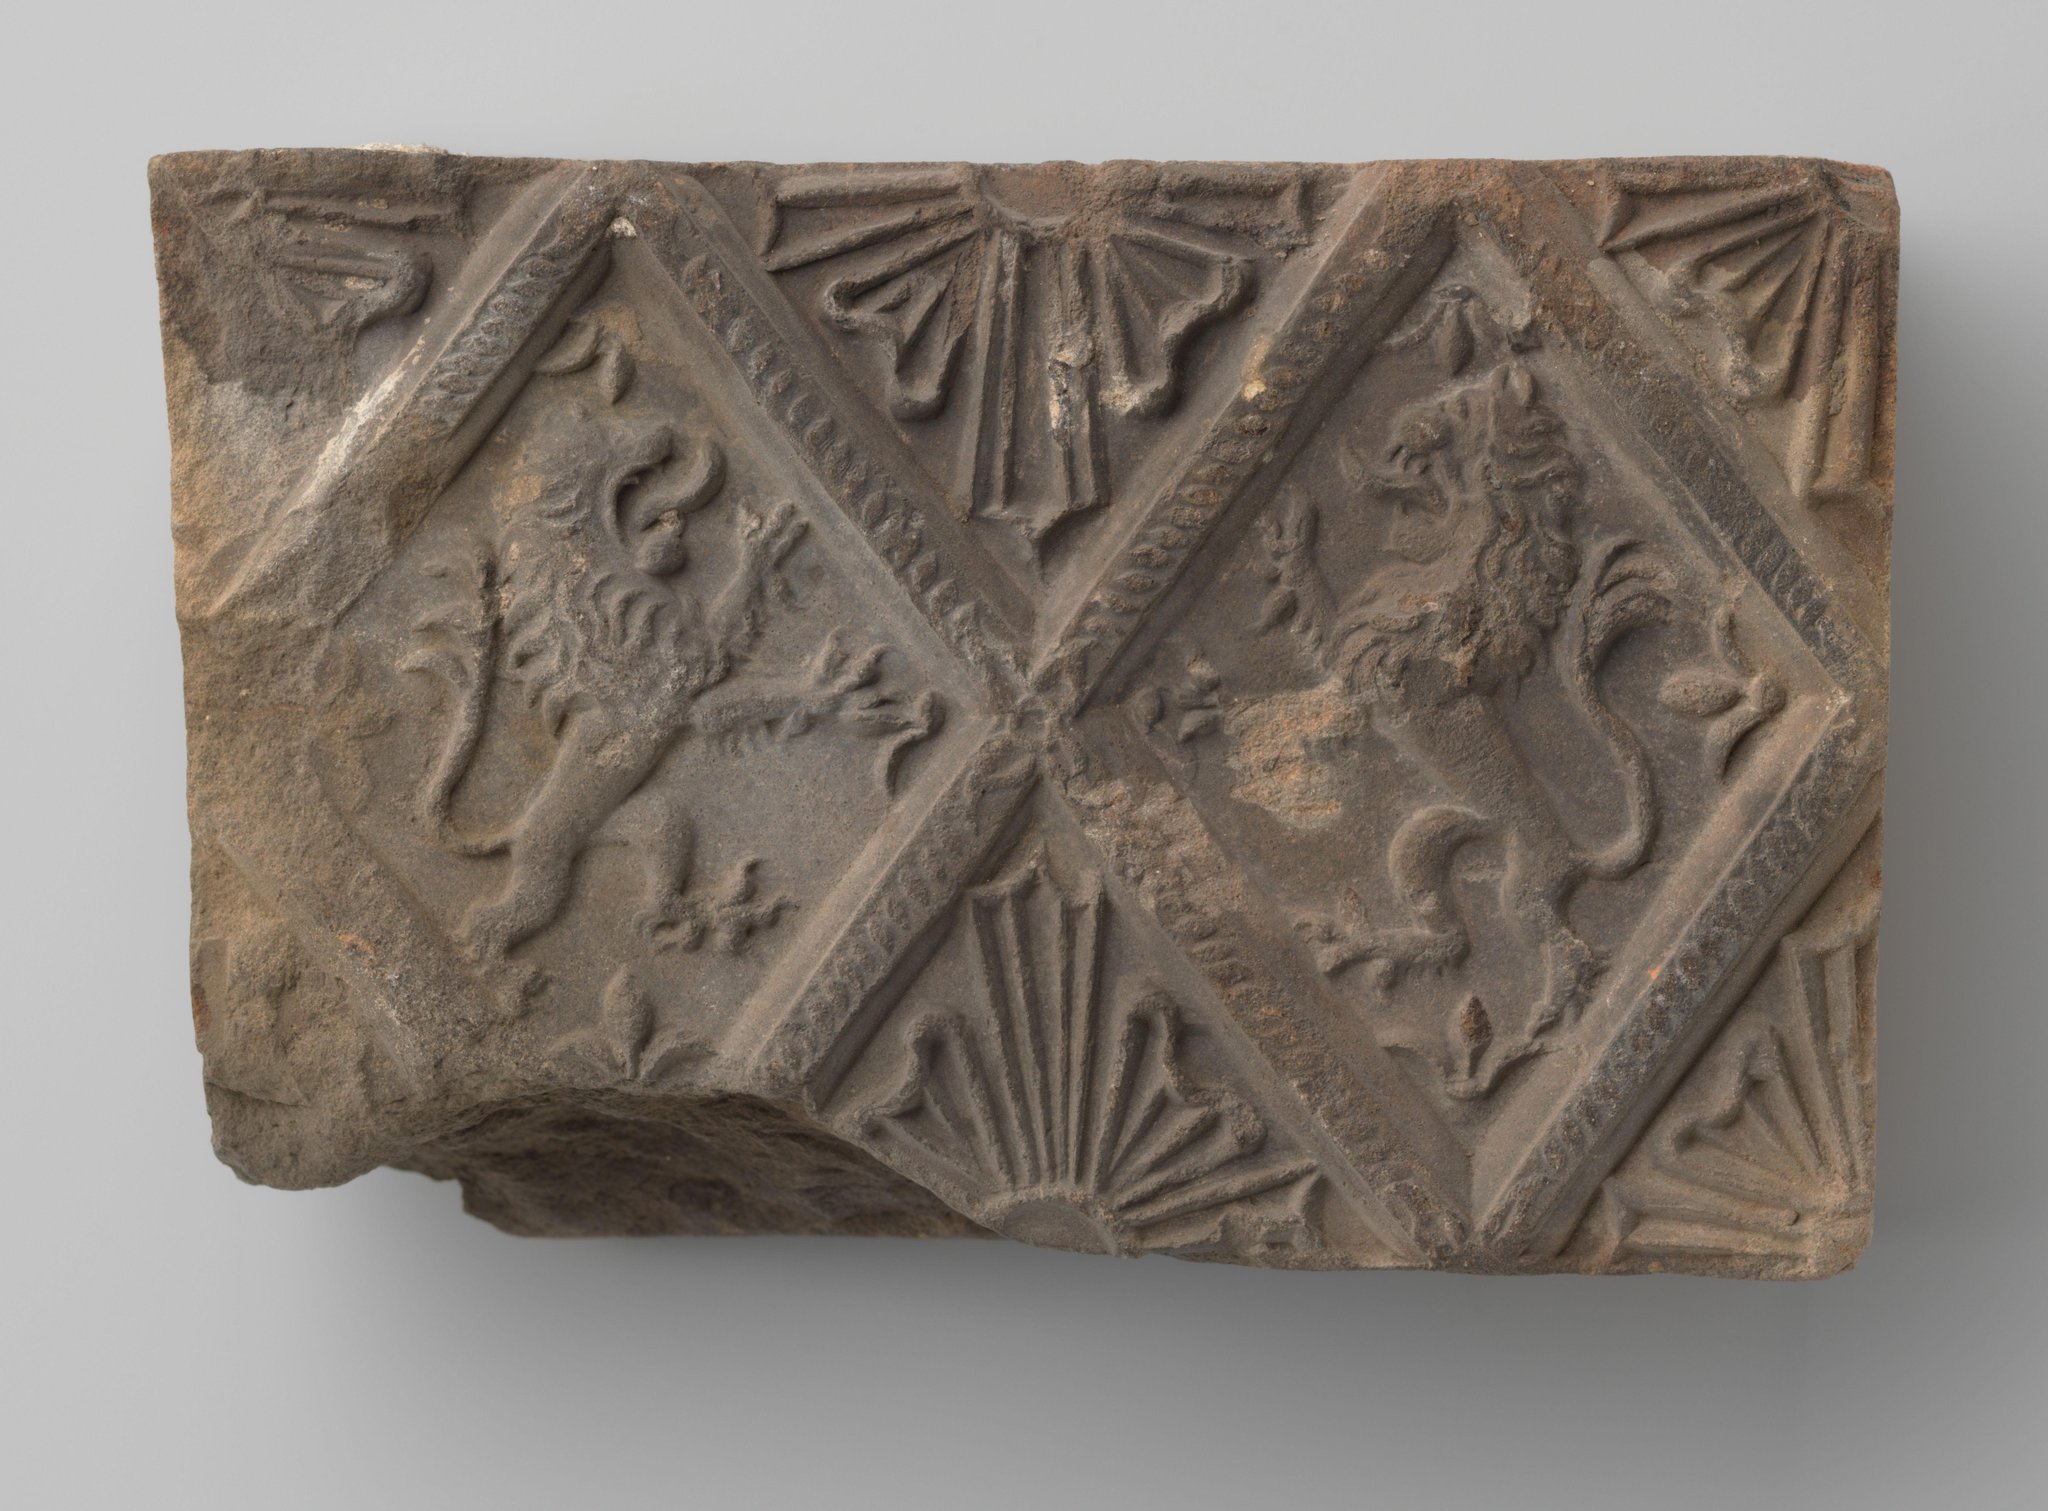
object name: hearthstone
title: Twee staande leeuwen in ruiten.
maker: Anonymous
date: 1500-1700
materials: earthenware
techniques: printing, firing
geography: southern netherlands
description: Rechthoekige haardsteen met ruitpatroon; staande leeuwen met kroon boven in de gehele ruiten, bladmotieven in overige vlakken, randen van de ruit versierd in reliëf.